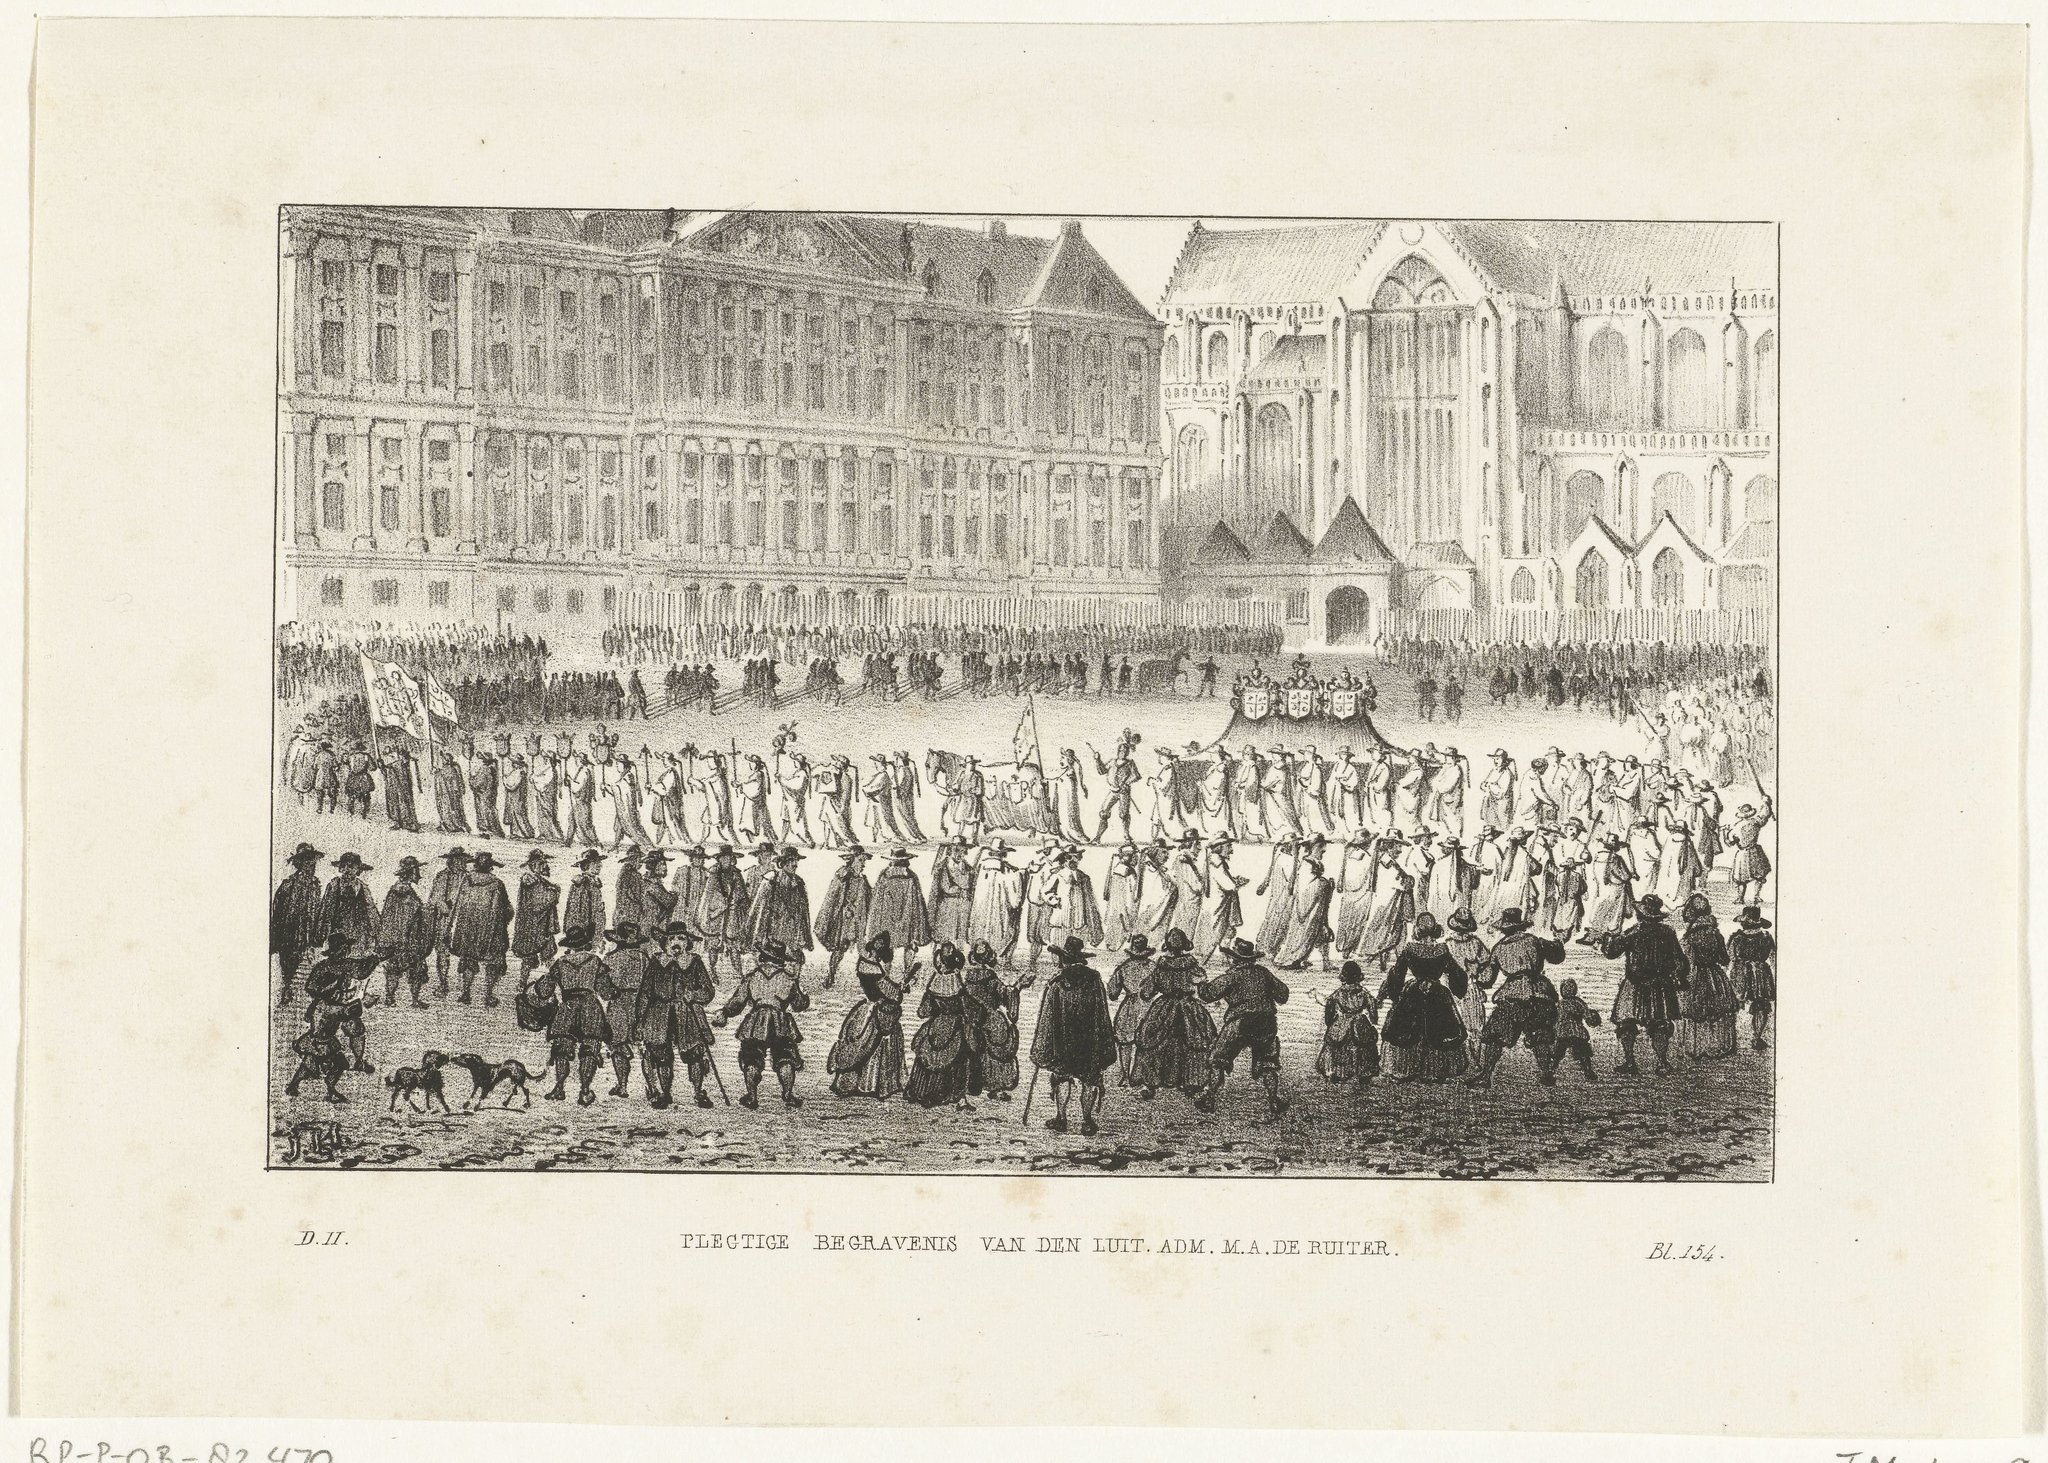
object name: history print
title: Plegtige begravenis van den luit. adm. de Ruiter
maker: Anonymous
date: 1800-1899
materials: paper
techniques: lithograph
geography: netherlands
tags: flushing, michiel adriaenszoon de ruyter, funerary ceremonial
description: De begrafenisstoet van Michiel Adriaenszoon de Ruyter op 18 maart 1677. De begrafenisstoet gaande over de Dam langs het stadhuis naar de Nieuwe Kerk te Amsterdam. Gemrkt onderaan: D. II / Bl. 154.